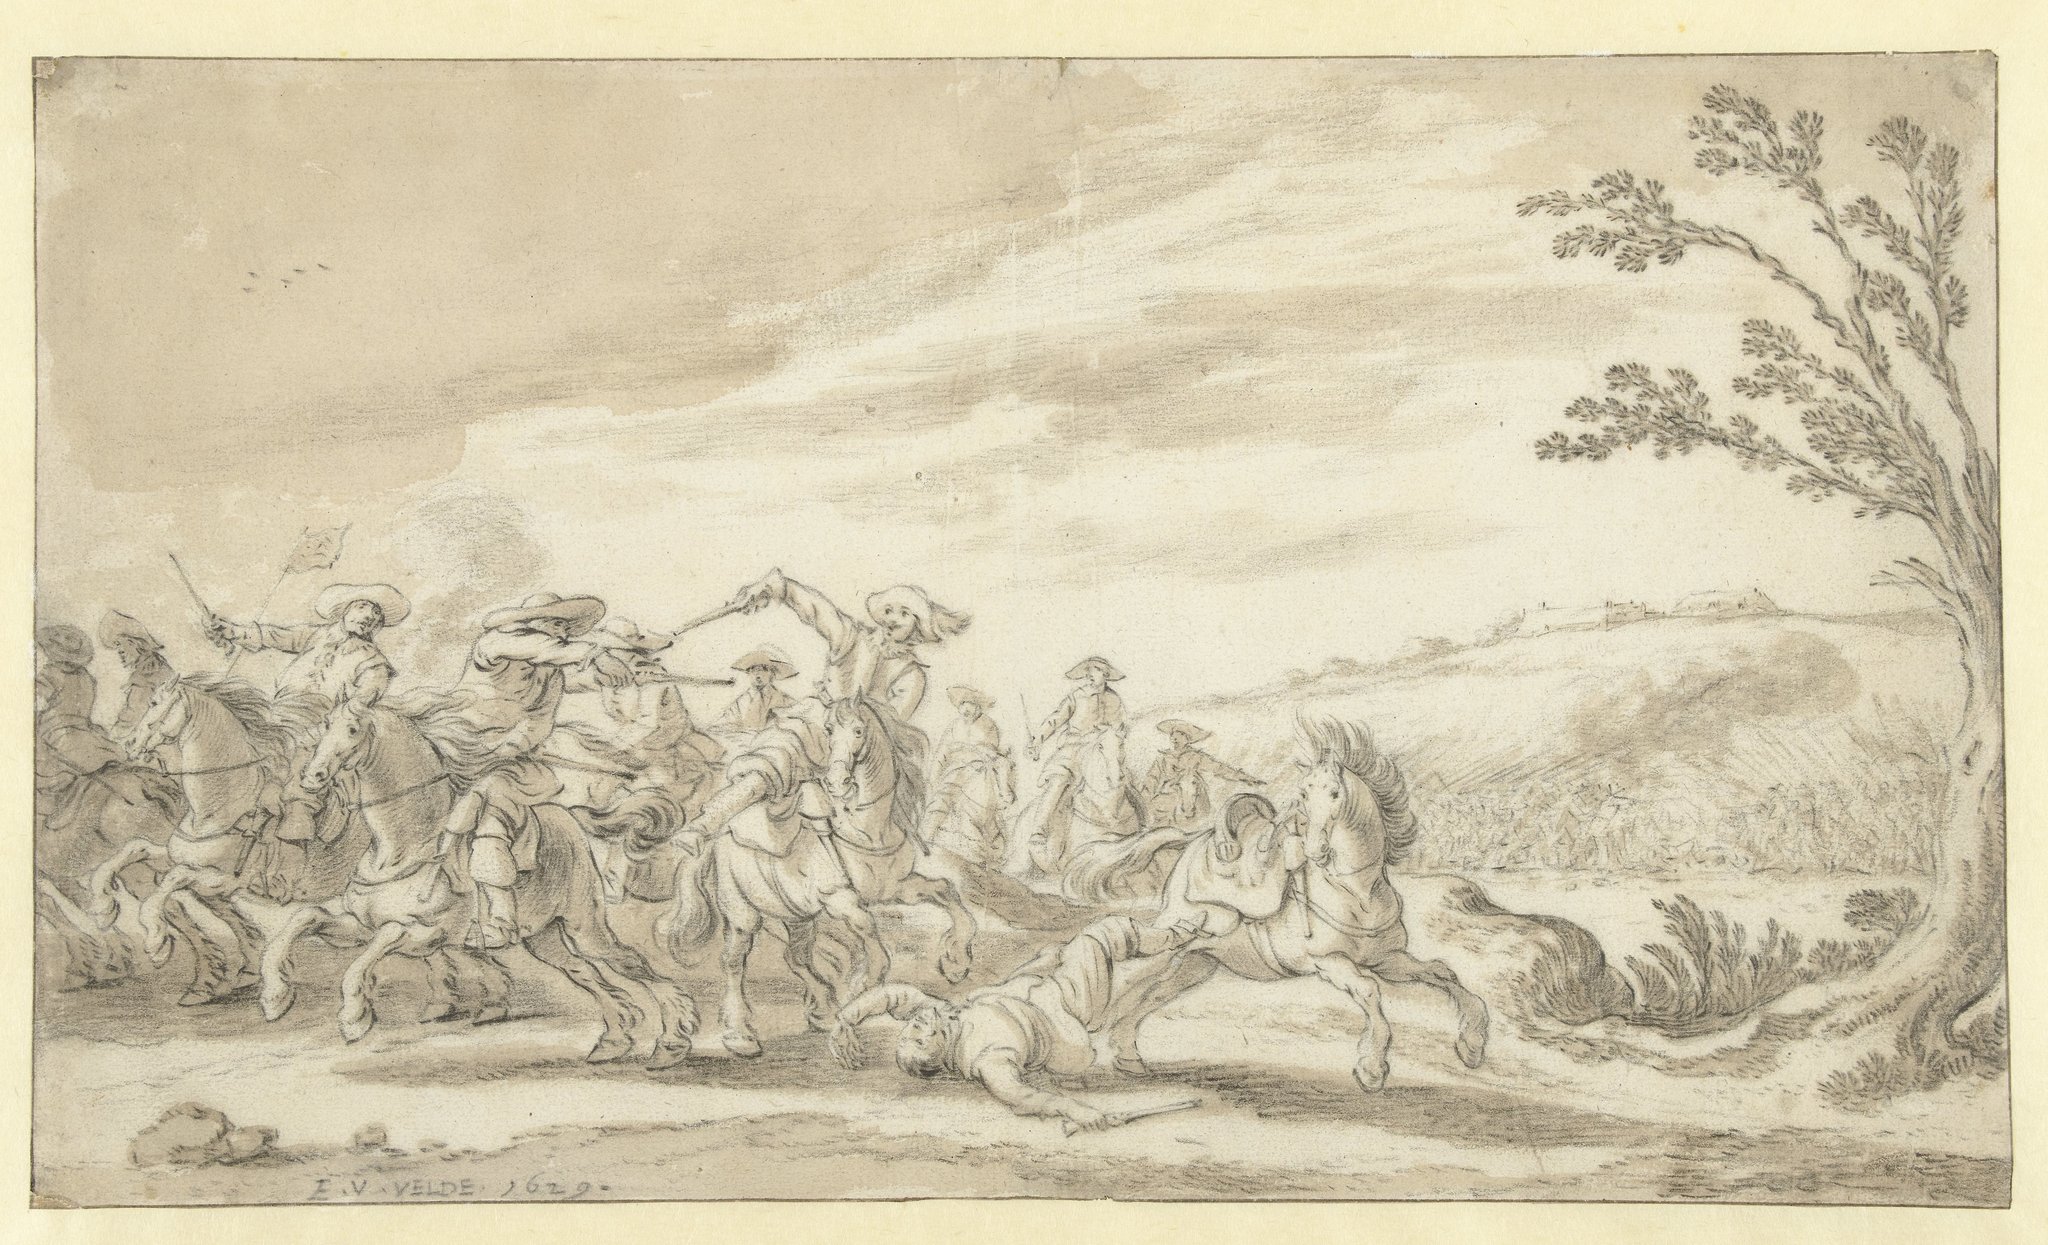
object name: drawing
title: Ruitergevecht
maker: esaias van de velde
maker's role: draughtsman, painter, print maker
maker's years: 1587-1630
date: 1629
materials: chalk, paper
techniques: brush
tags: battle (+ cavalry, horsemen)